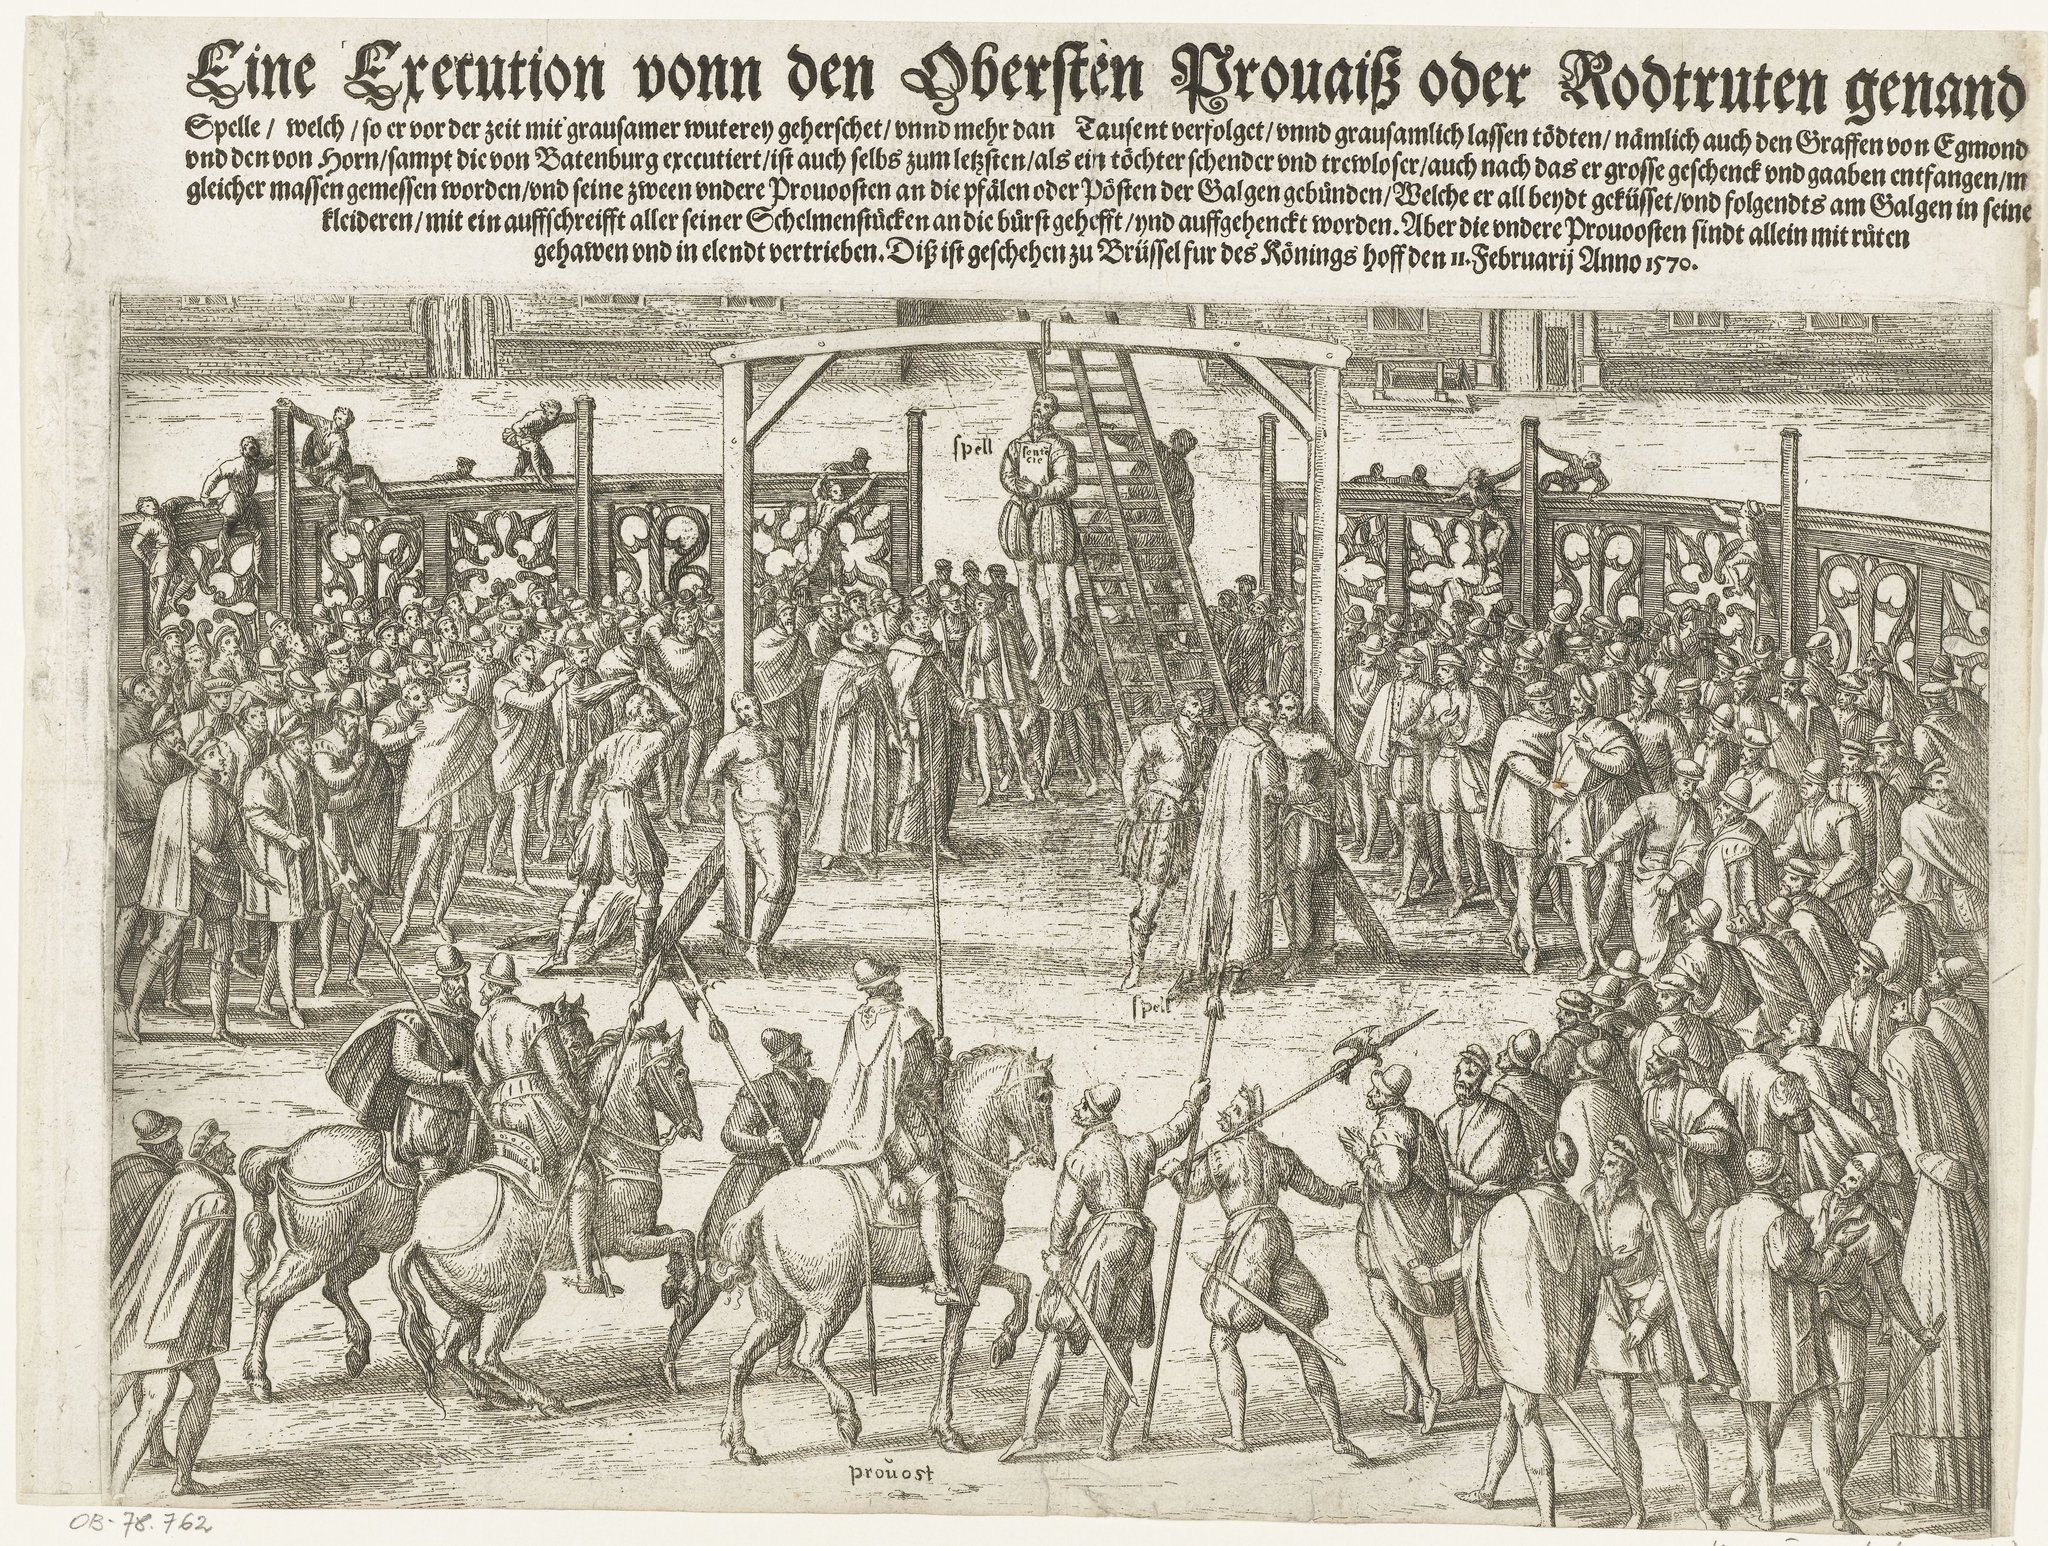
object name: print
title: Eine Execution vonn de Obersten Provaiß oder Rodtruten genand Spelle (...)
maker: frans hogenberg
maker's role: print maker, publisher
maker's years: 1538-1590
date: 1570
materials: paper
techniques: etching, letterpress printing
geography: cologne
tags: violent death by hanging, brussels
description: Executie door ophanging op last van Alva van de provoost Hans de Greef, alias Spell of Spelleken te Brussel, 11 februari 1570. Rechts kust Spell een van zijn medewerkers. In het midden hangt Spell aan de galg met zijn vonnis (sentencie) op de borst. Links wordt een andere van zijn medewerkers wordt gegeseld. Dit is de oorspronkelijke grote nog onafgesneden plaat van nr. 119. Zonder onderschrift maar met titel en opschrift van 5 regels in het Duits.